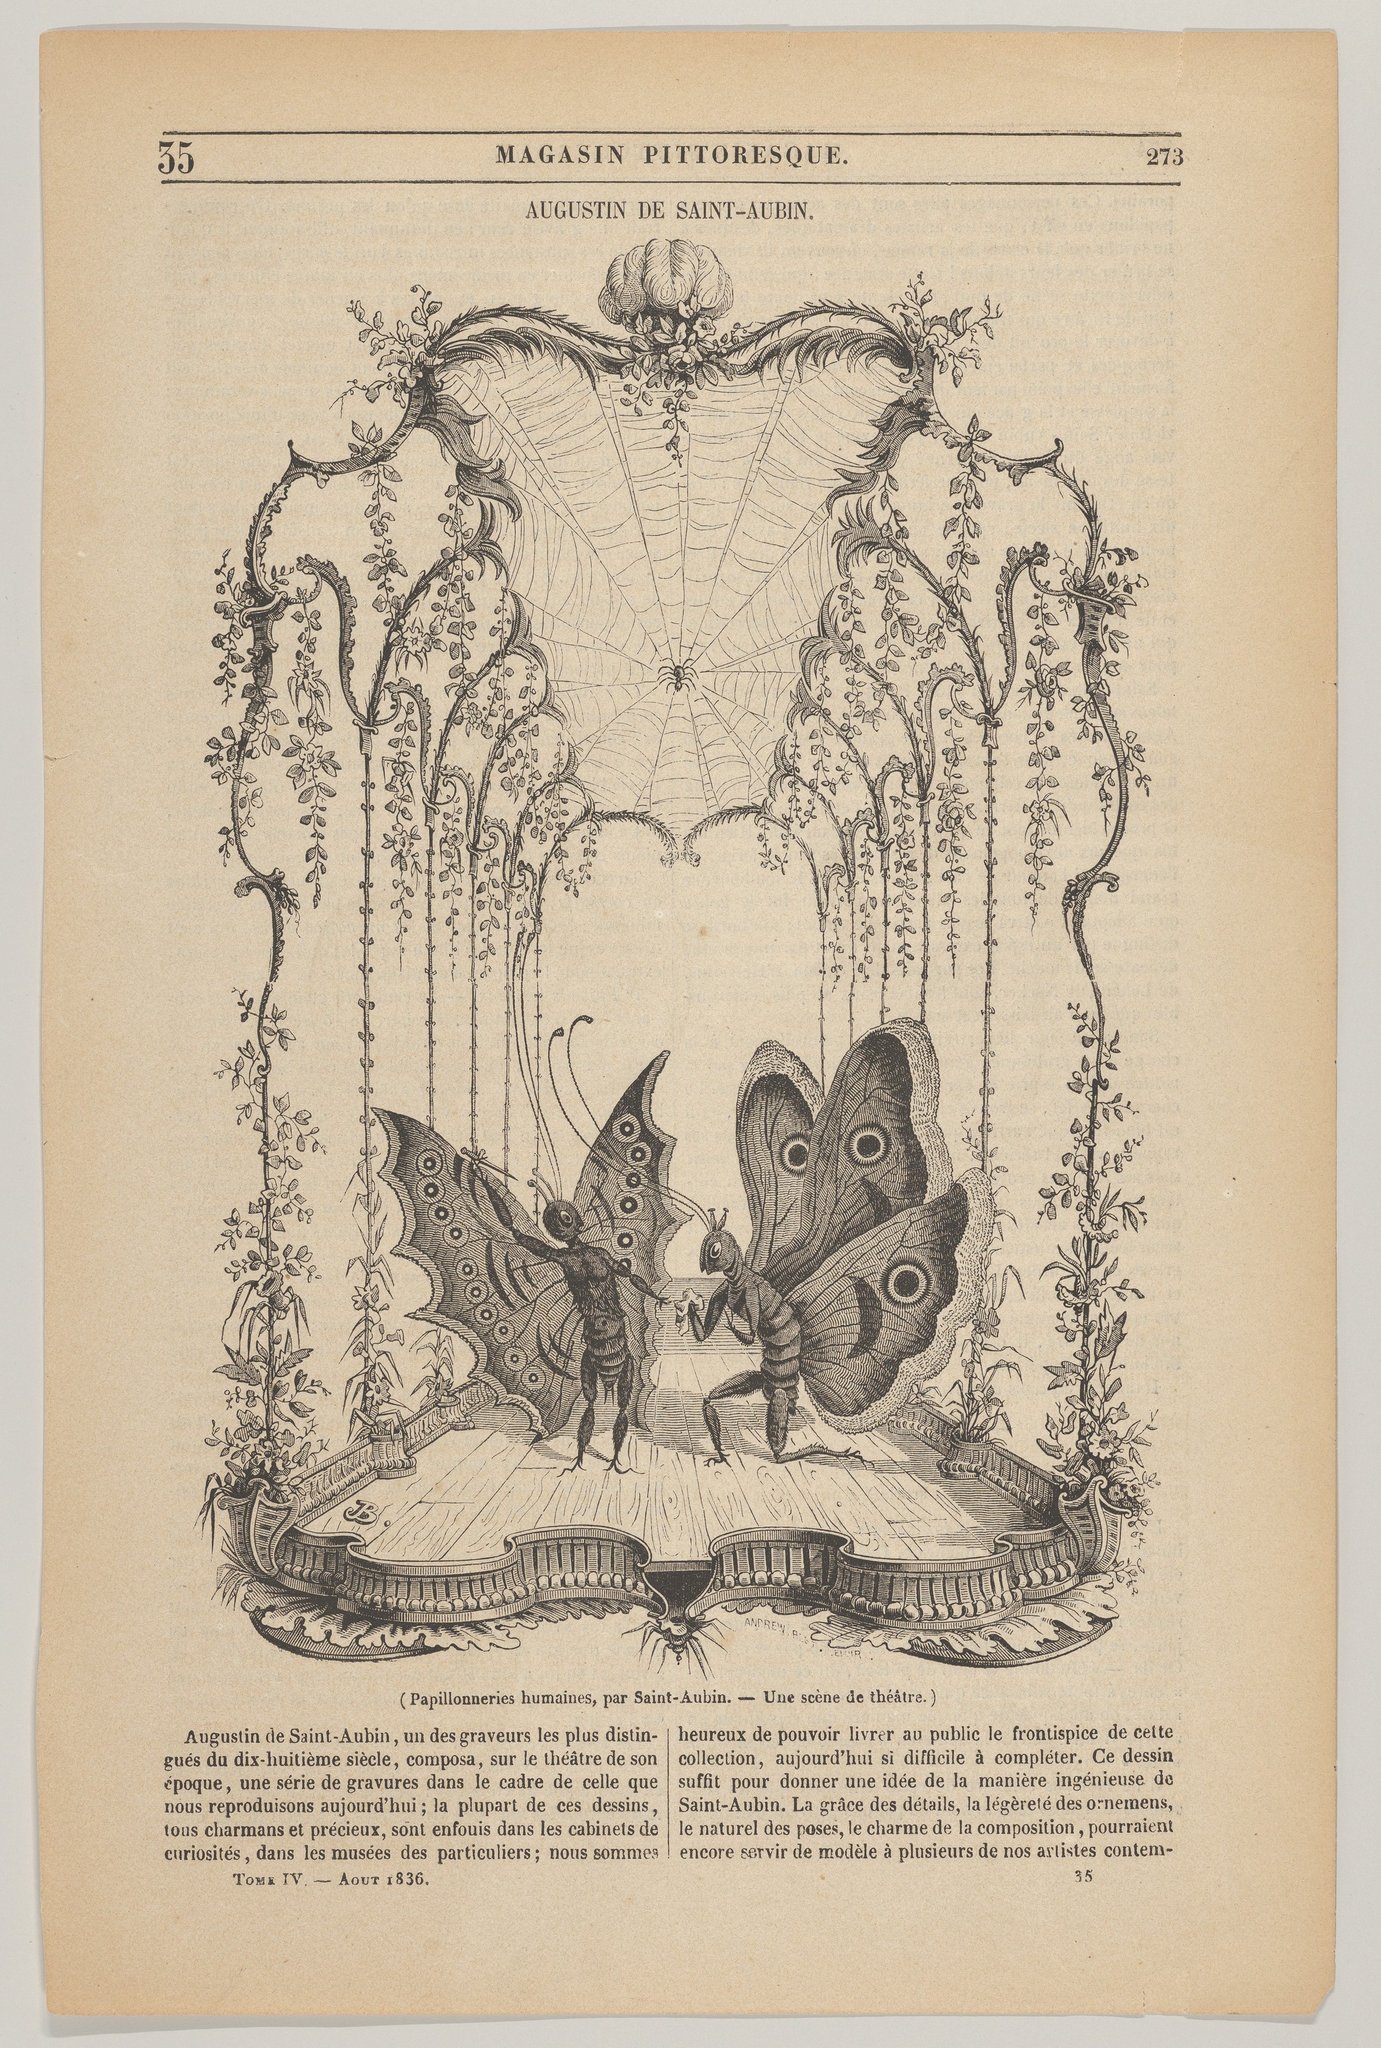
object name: print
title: Papillonneries Humains, from "Le Magasin Pittoresque"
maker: augustin de saint-aubin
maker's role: artist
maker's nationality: french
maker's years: 1736-1807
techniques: engraving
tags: insects,butterflies